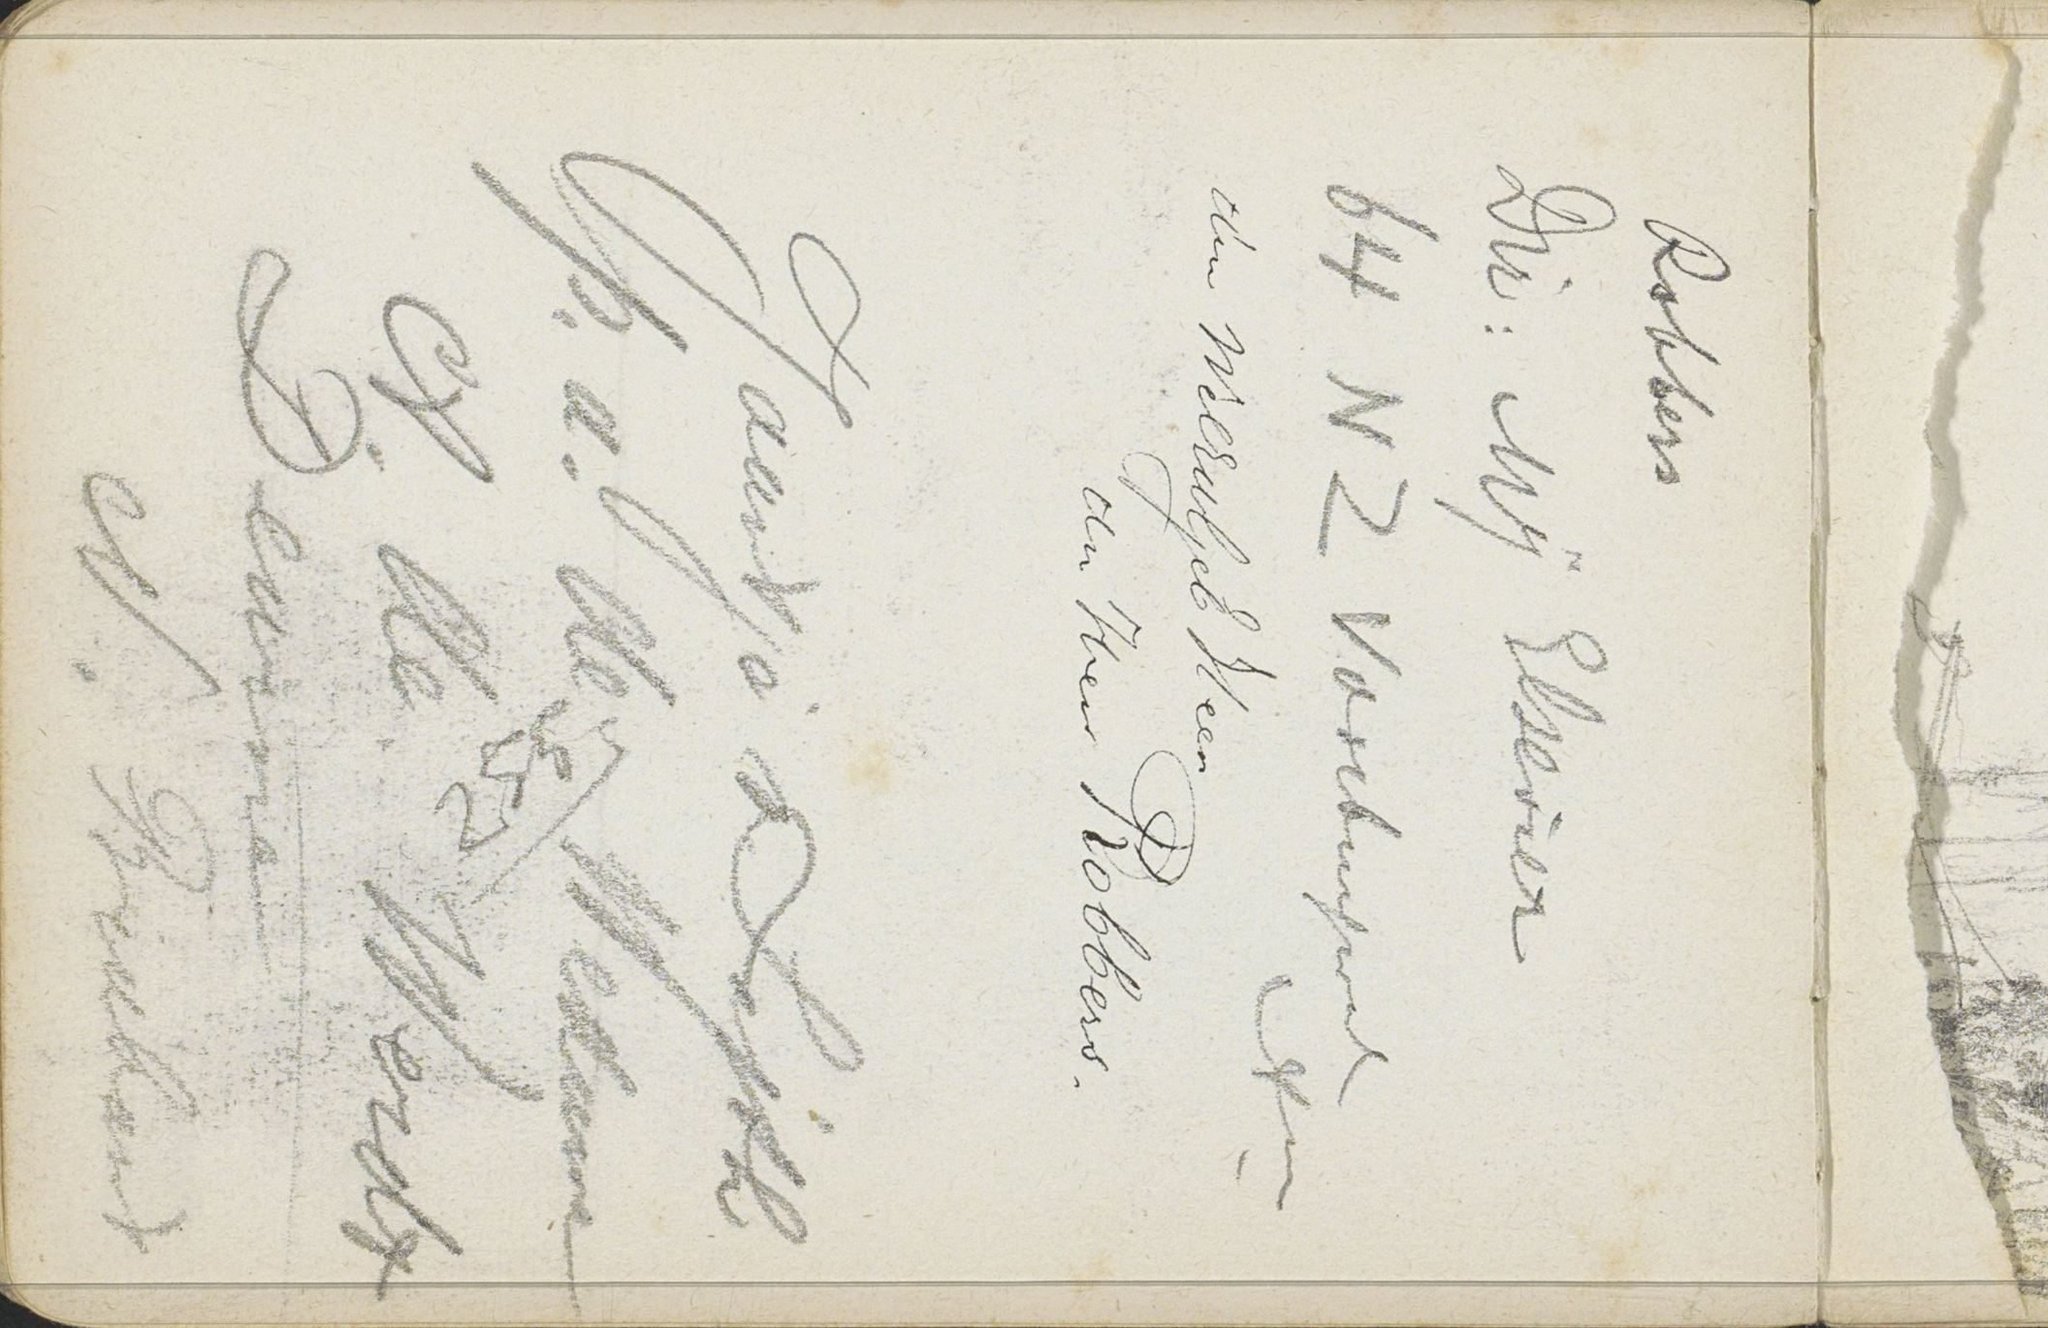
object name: sketchbook leaf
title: Notities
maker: willem cornelis rip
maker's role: draughtsman, painter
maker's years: 1856-1922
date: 1866-1922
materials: ink, paper, pencil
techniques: pen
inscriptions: annotation: ‘Robbers/ [...] Elsevier/ 64 NZ Voorburgwal/ Am/ den Weledelgeb Heer/ den Heer Robbers/ Jaantje v. L[...]th p.a. de Weduwe/ A/ de Werdt/ Deurne/N. Brabant’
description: Blad 7 verso uit een schetsboek met 42 bladen.